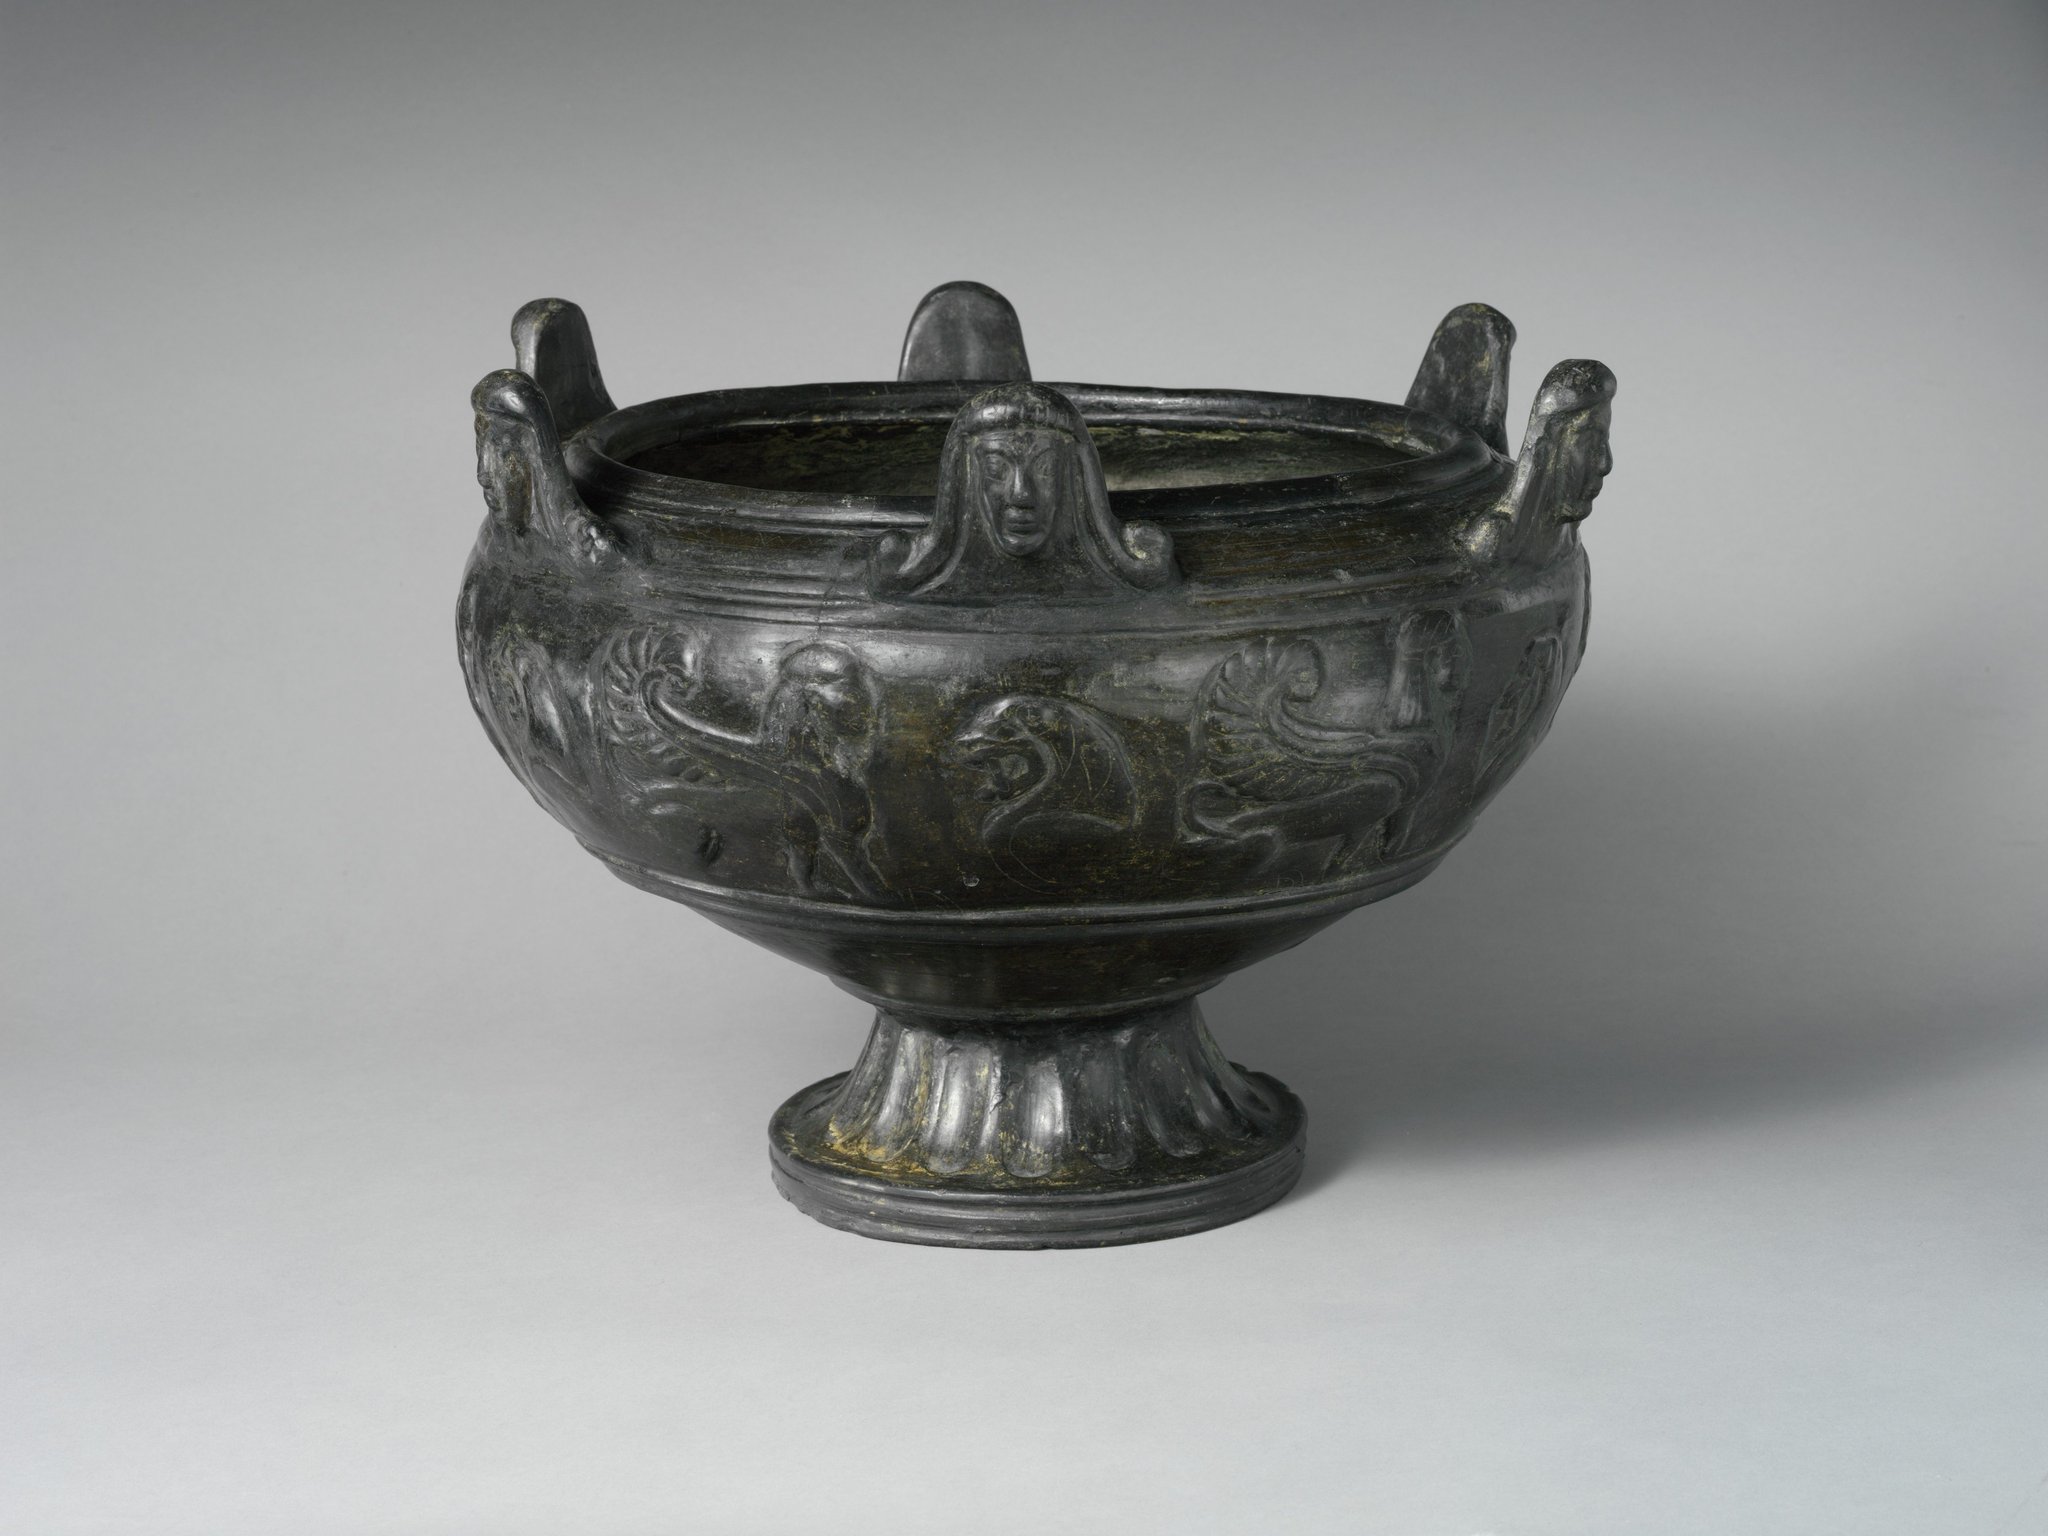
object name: krater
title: Terracotta krater (mixing bowl)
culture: etruscan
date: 550 BCE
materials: terracotta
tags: heads,sphinx,lions